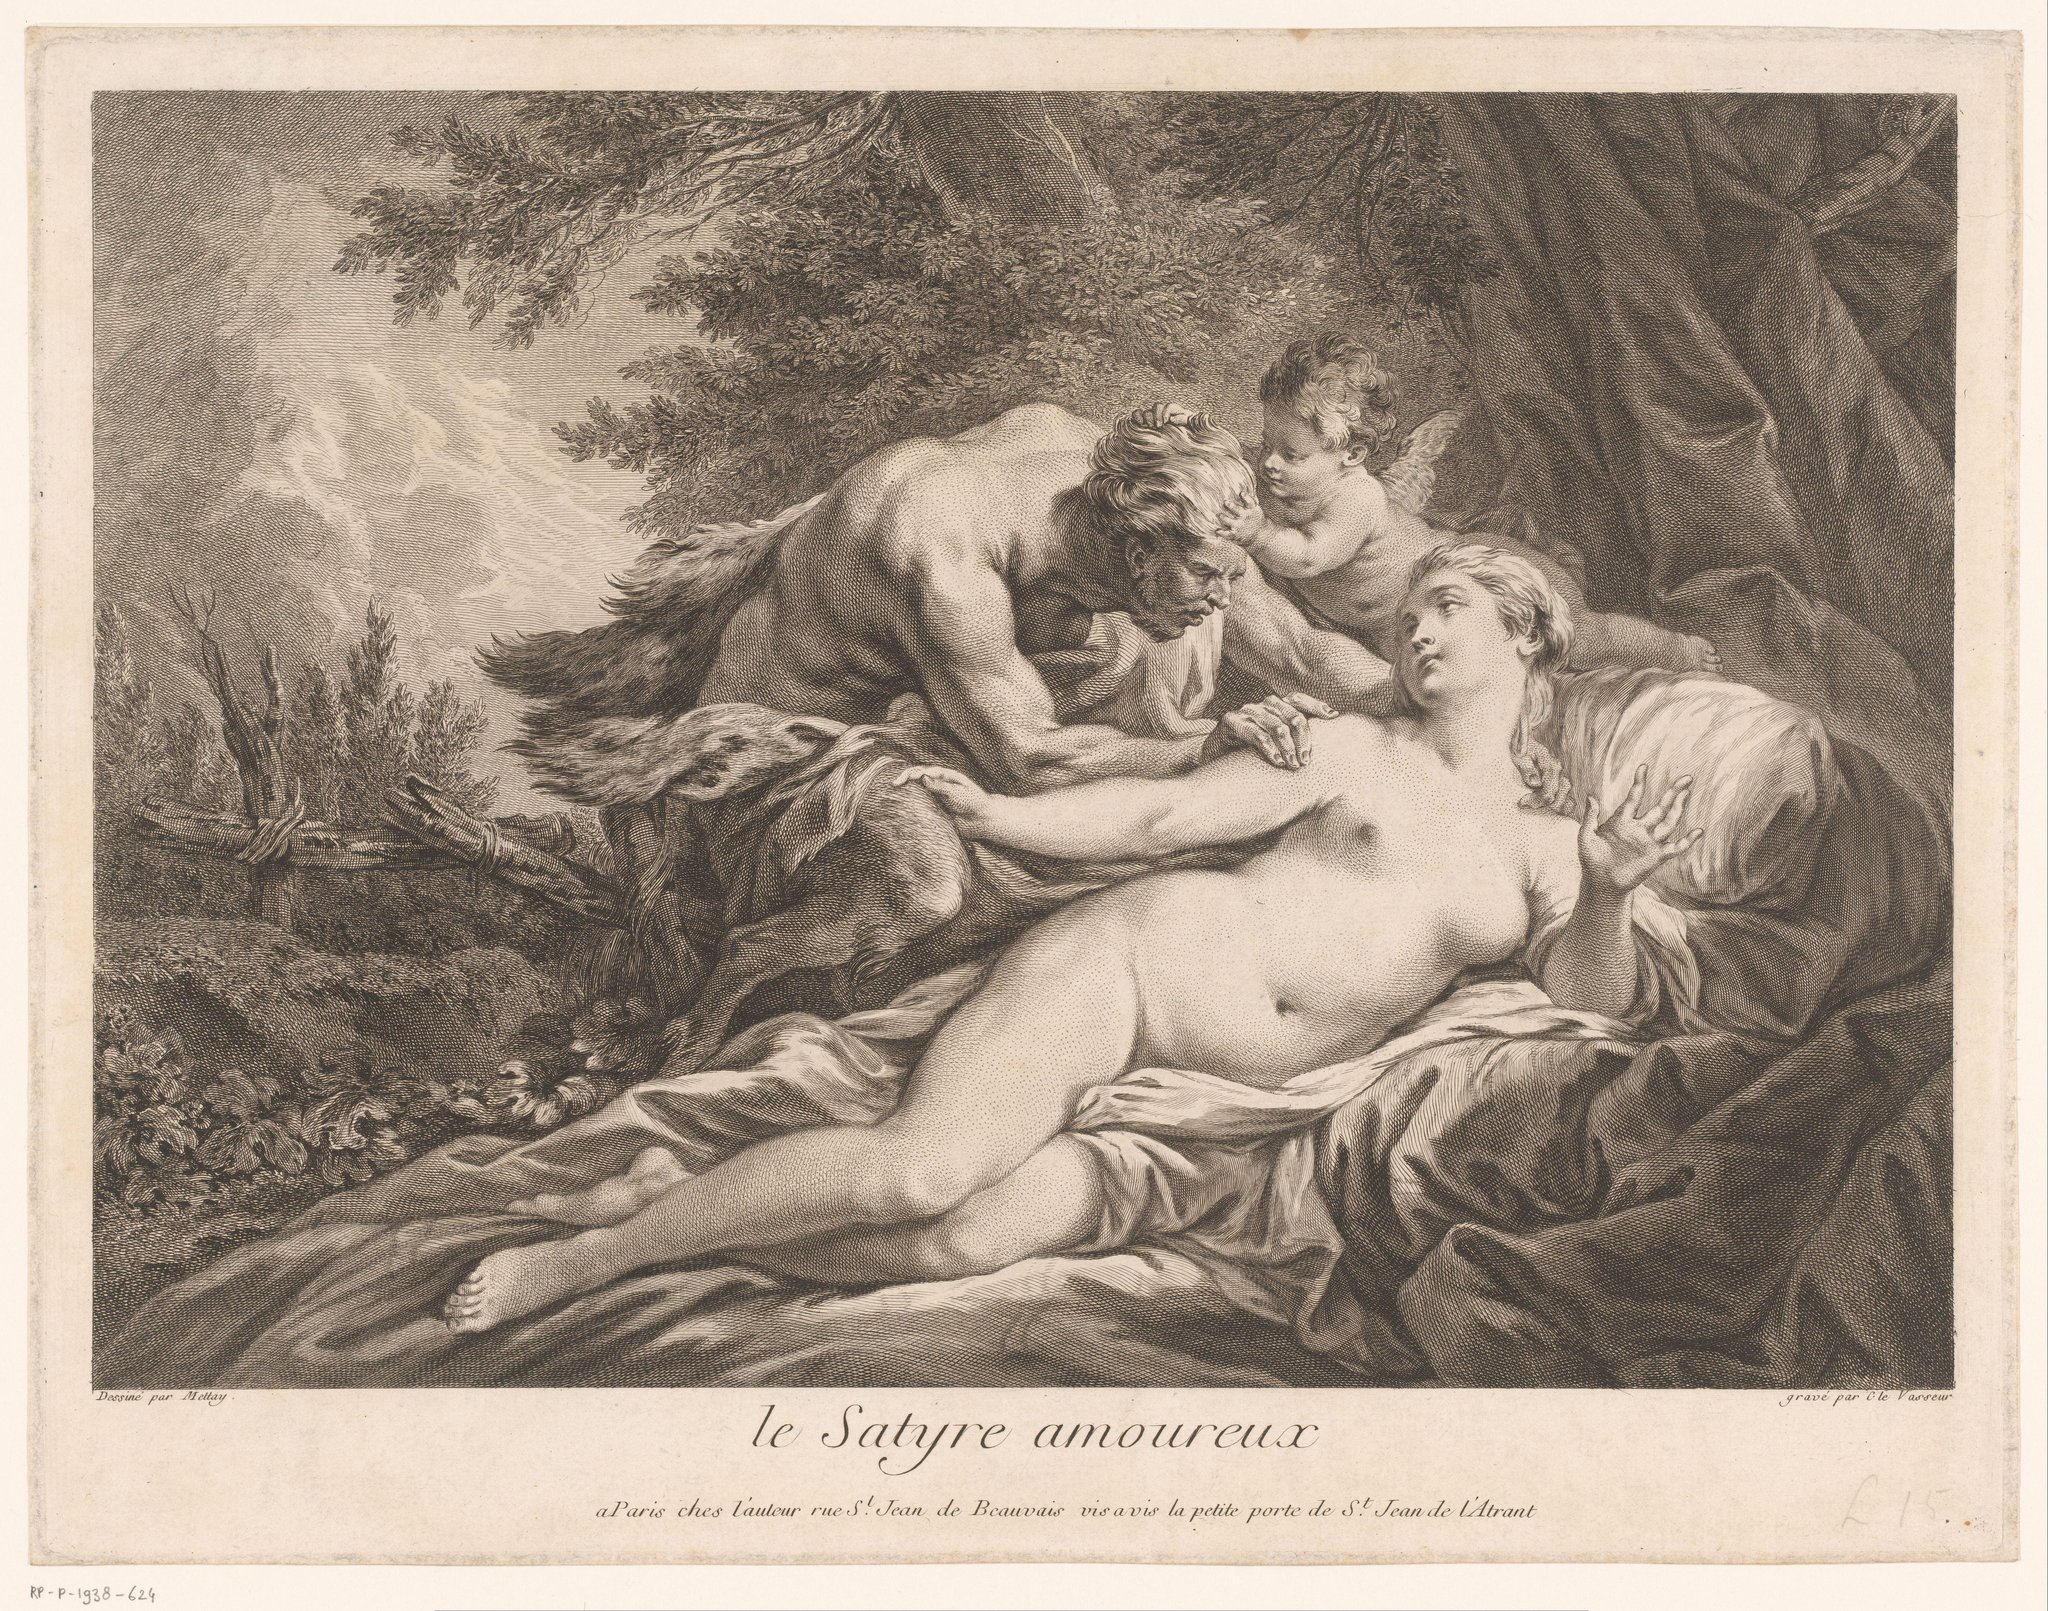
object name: print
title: Le Satyre amoureux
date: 1744-1816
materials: paper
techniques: engraving, etching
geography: paris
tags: jupiter, disguised as a satyr, approaches the sleeping antiope; the eagle may be standing nearby, satyr(s) (in general), (story of) antiope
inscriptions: collector's mark: Lugt 2760, collector's mark: Lugt 2228